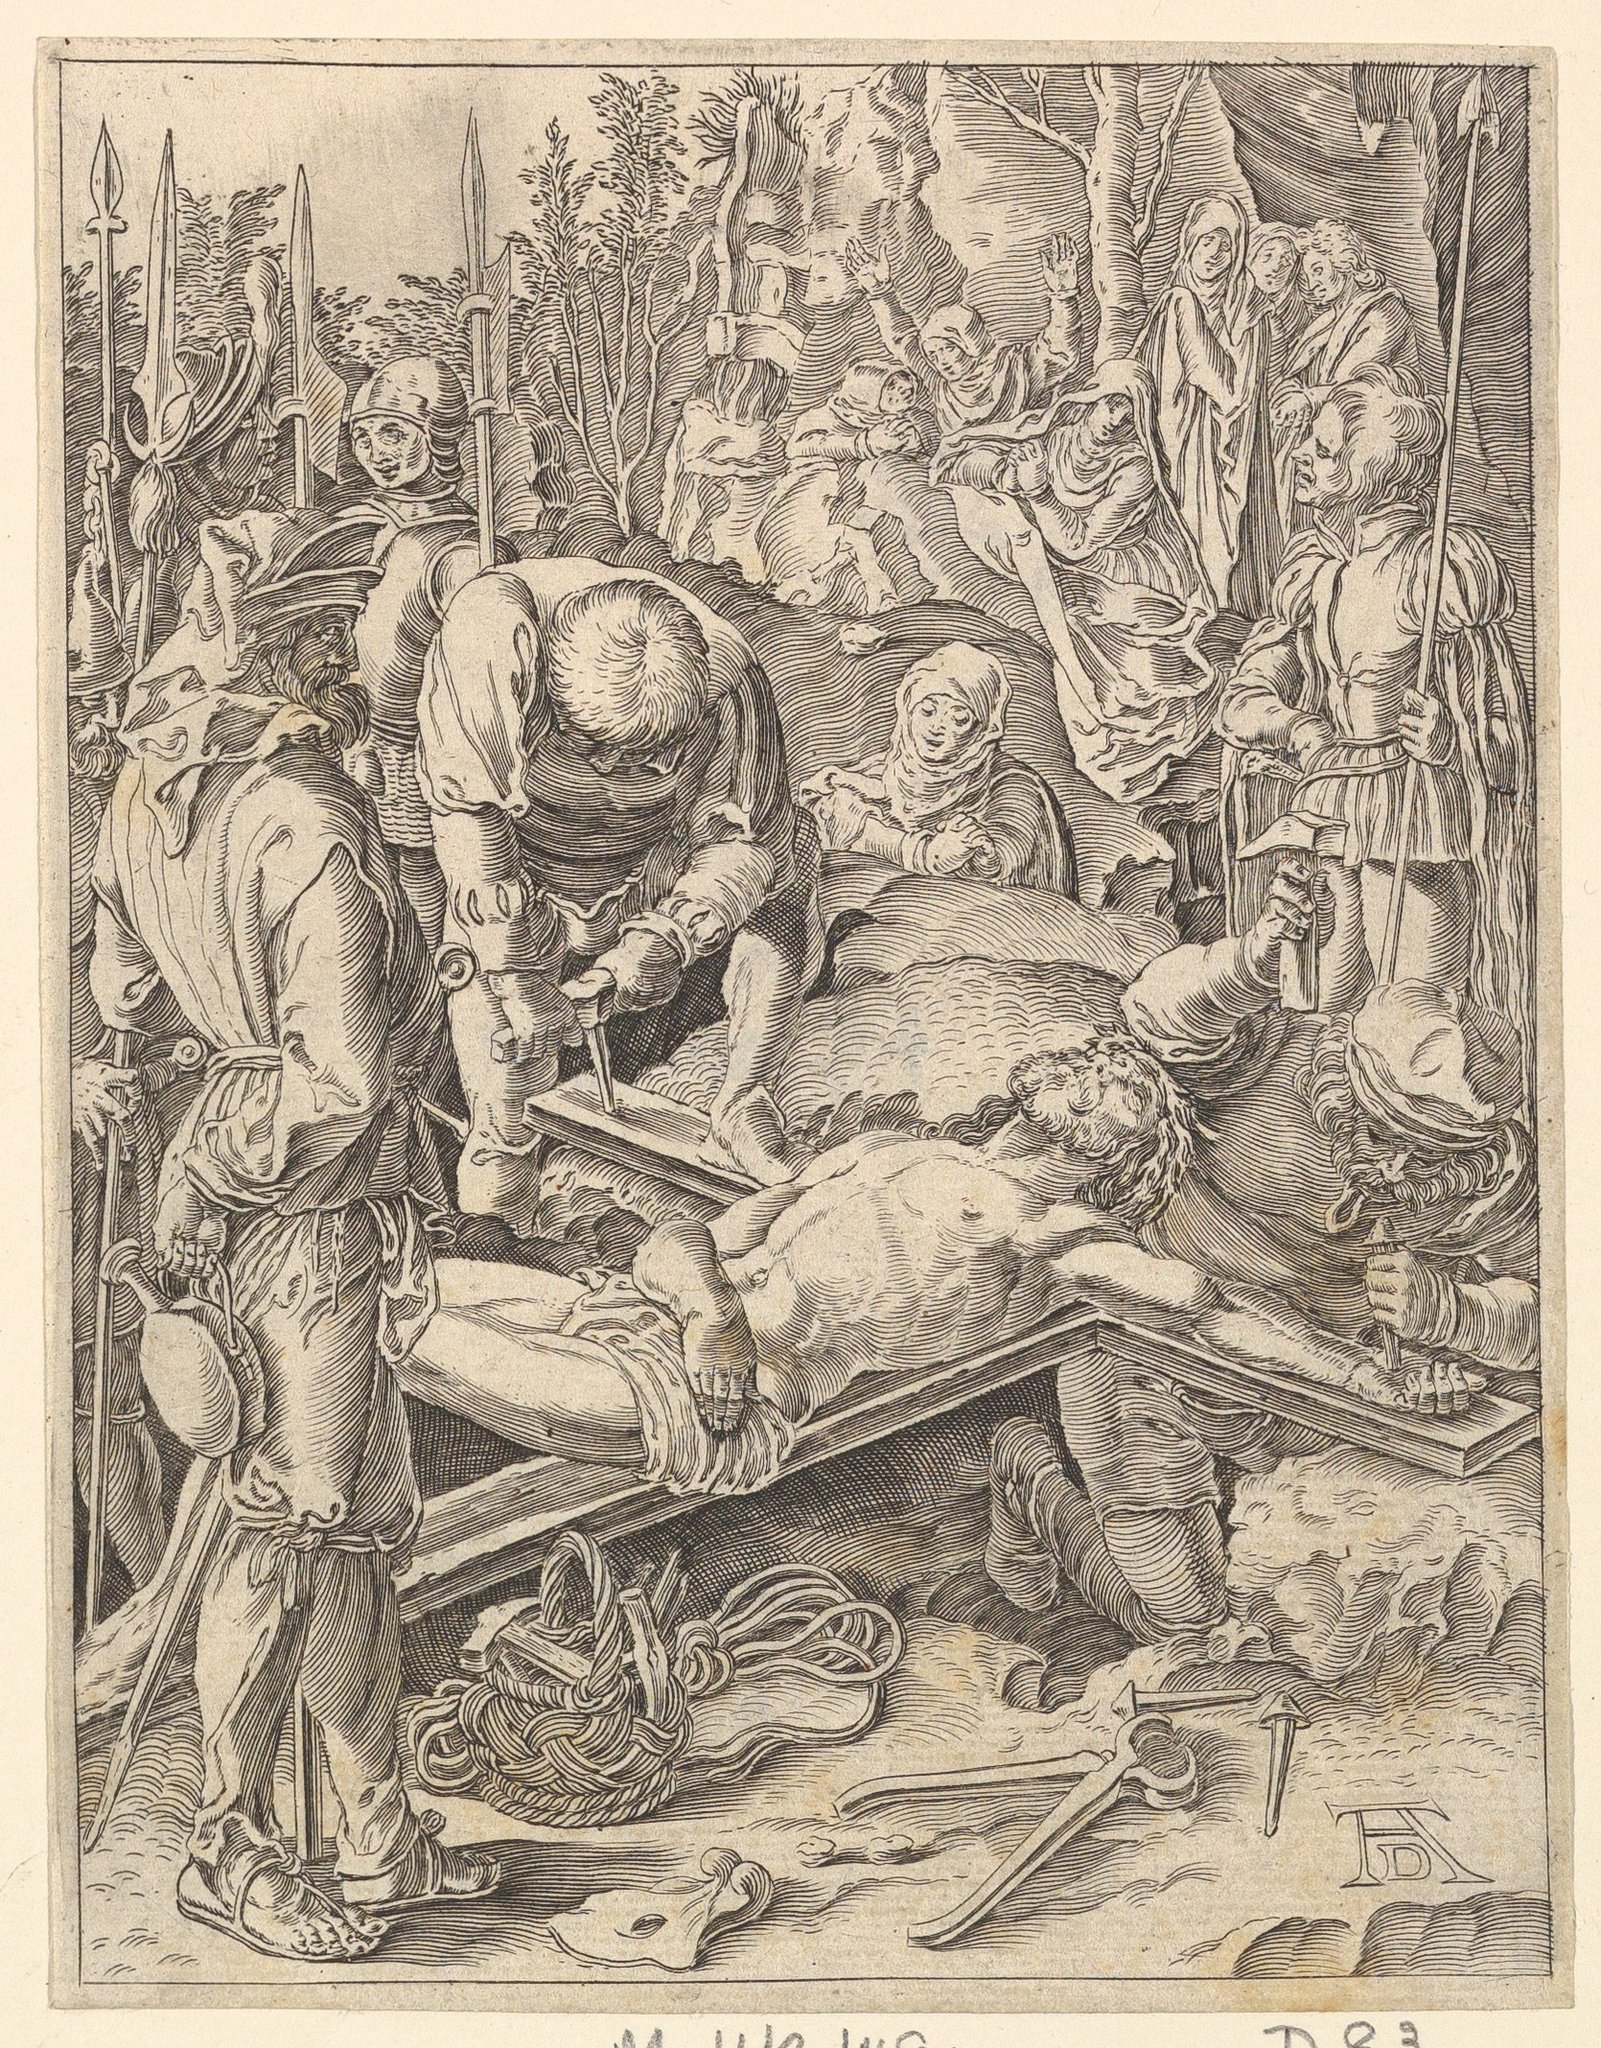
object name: print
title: Engraved copies of The Little Passion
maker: albrecht dürer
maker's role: artist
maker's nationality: german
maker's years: 1471-1528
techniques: engraving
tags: soldiers,weapons,cross,jesus,crucifixion